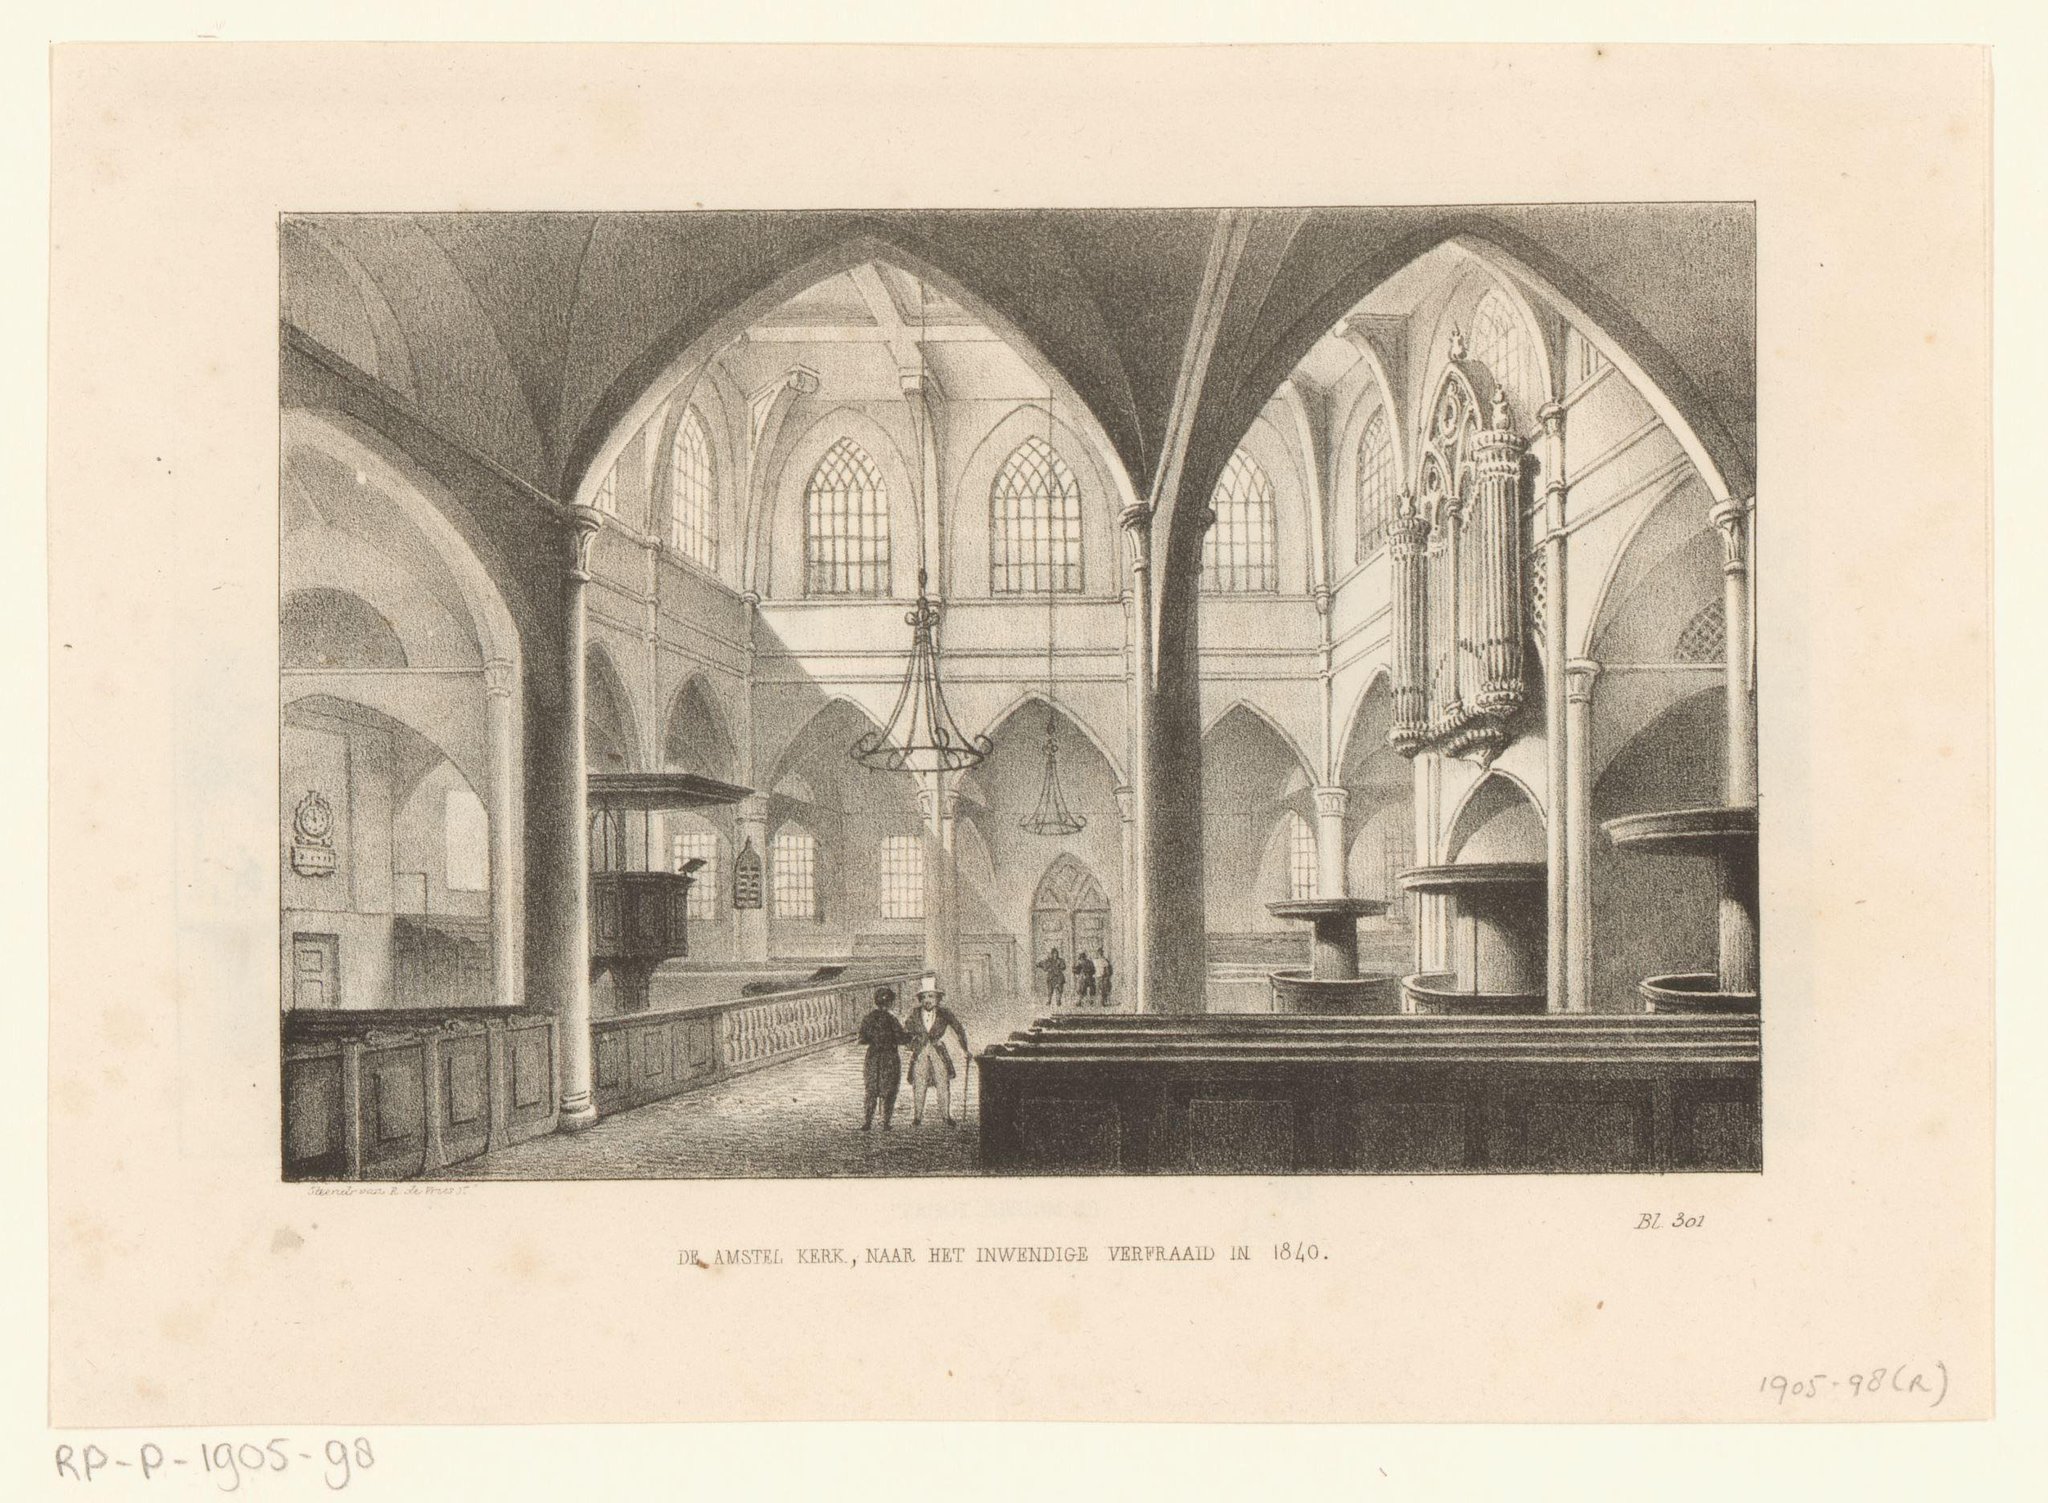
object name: book illustration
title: De Amstel kerk, naar het inwendige verfraaid in 1840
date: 1844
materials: paper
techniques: lithograph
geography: amsterdam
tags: interior of church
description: Prent uit: Vijver, C. van der. Geschiedkundige beschrijving der stad Amsterdam. Amsterdam: Diederichs, Gebroeders, 1844.